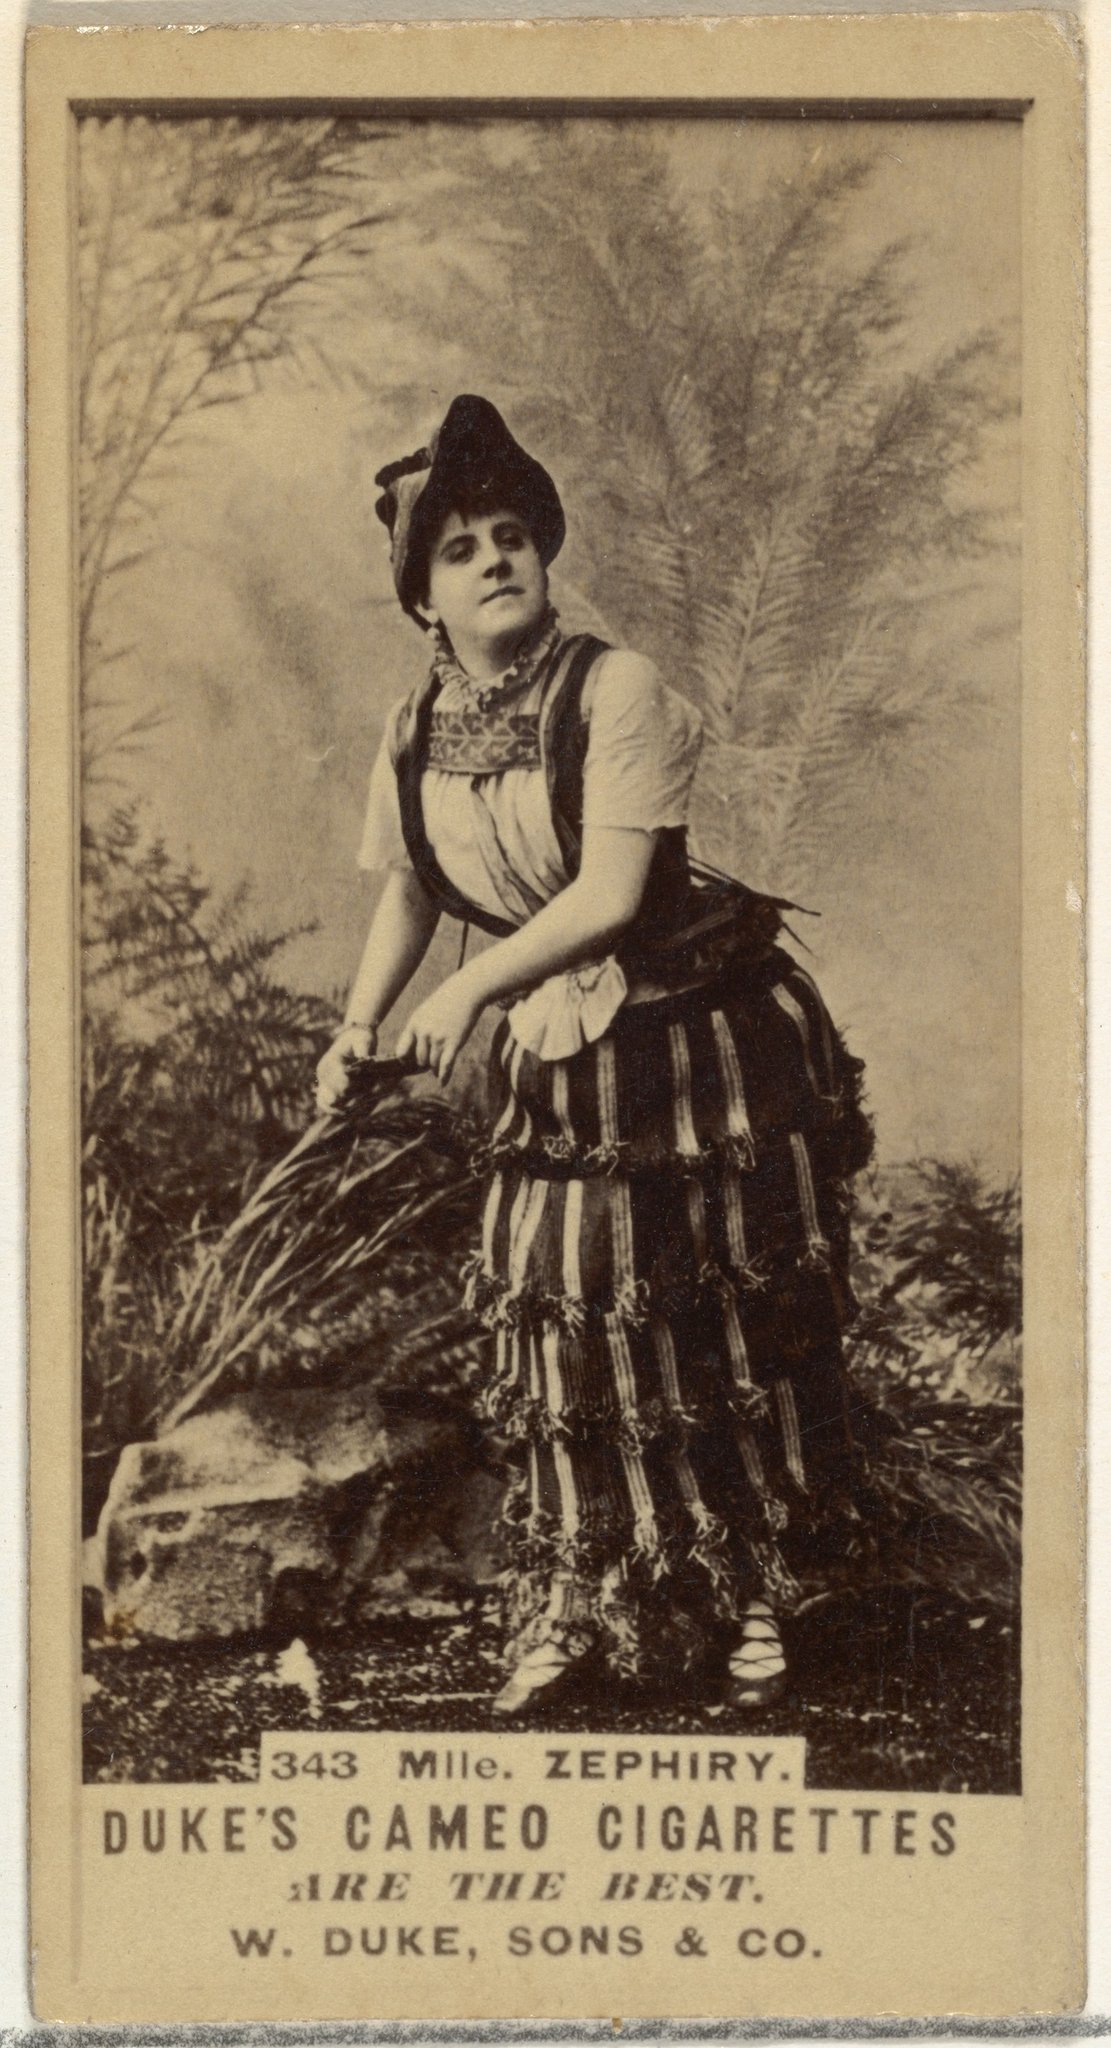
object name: photograph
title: Card Number 343, Mlle. Zephiry, from the Actors and Actresses series (N145-5) issued by Duke Sons & Co. to promote Cameo Cigarettes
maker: w. duke, sons & co.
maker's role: publisher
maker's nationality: american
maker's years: 1870-1920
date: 1880-1889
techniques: albumen silver print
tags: portraits,women,actresses